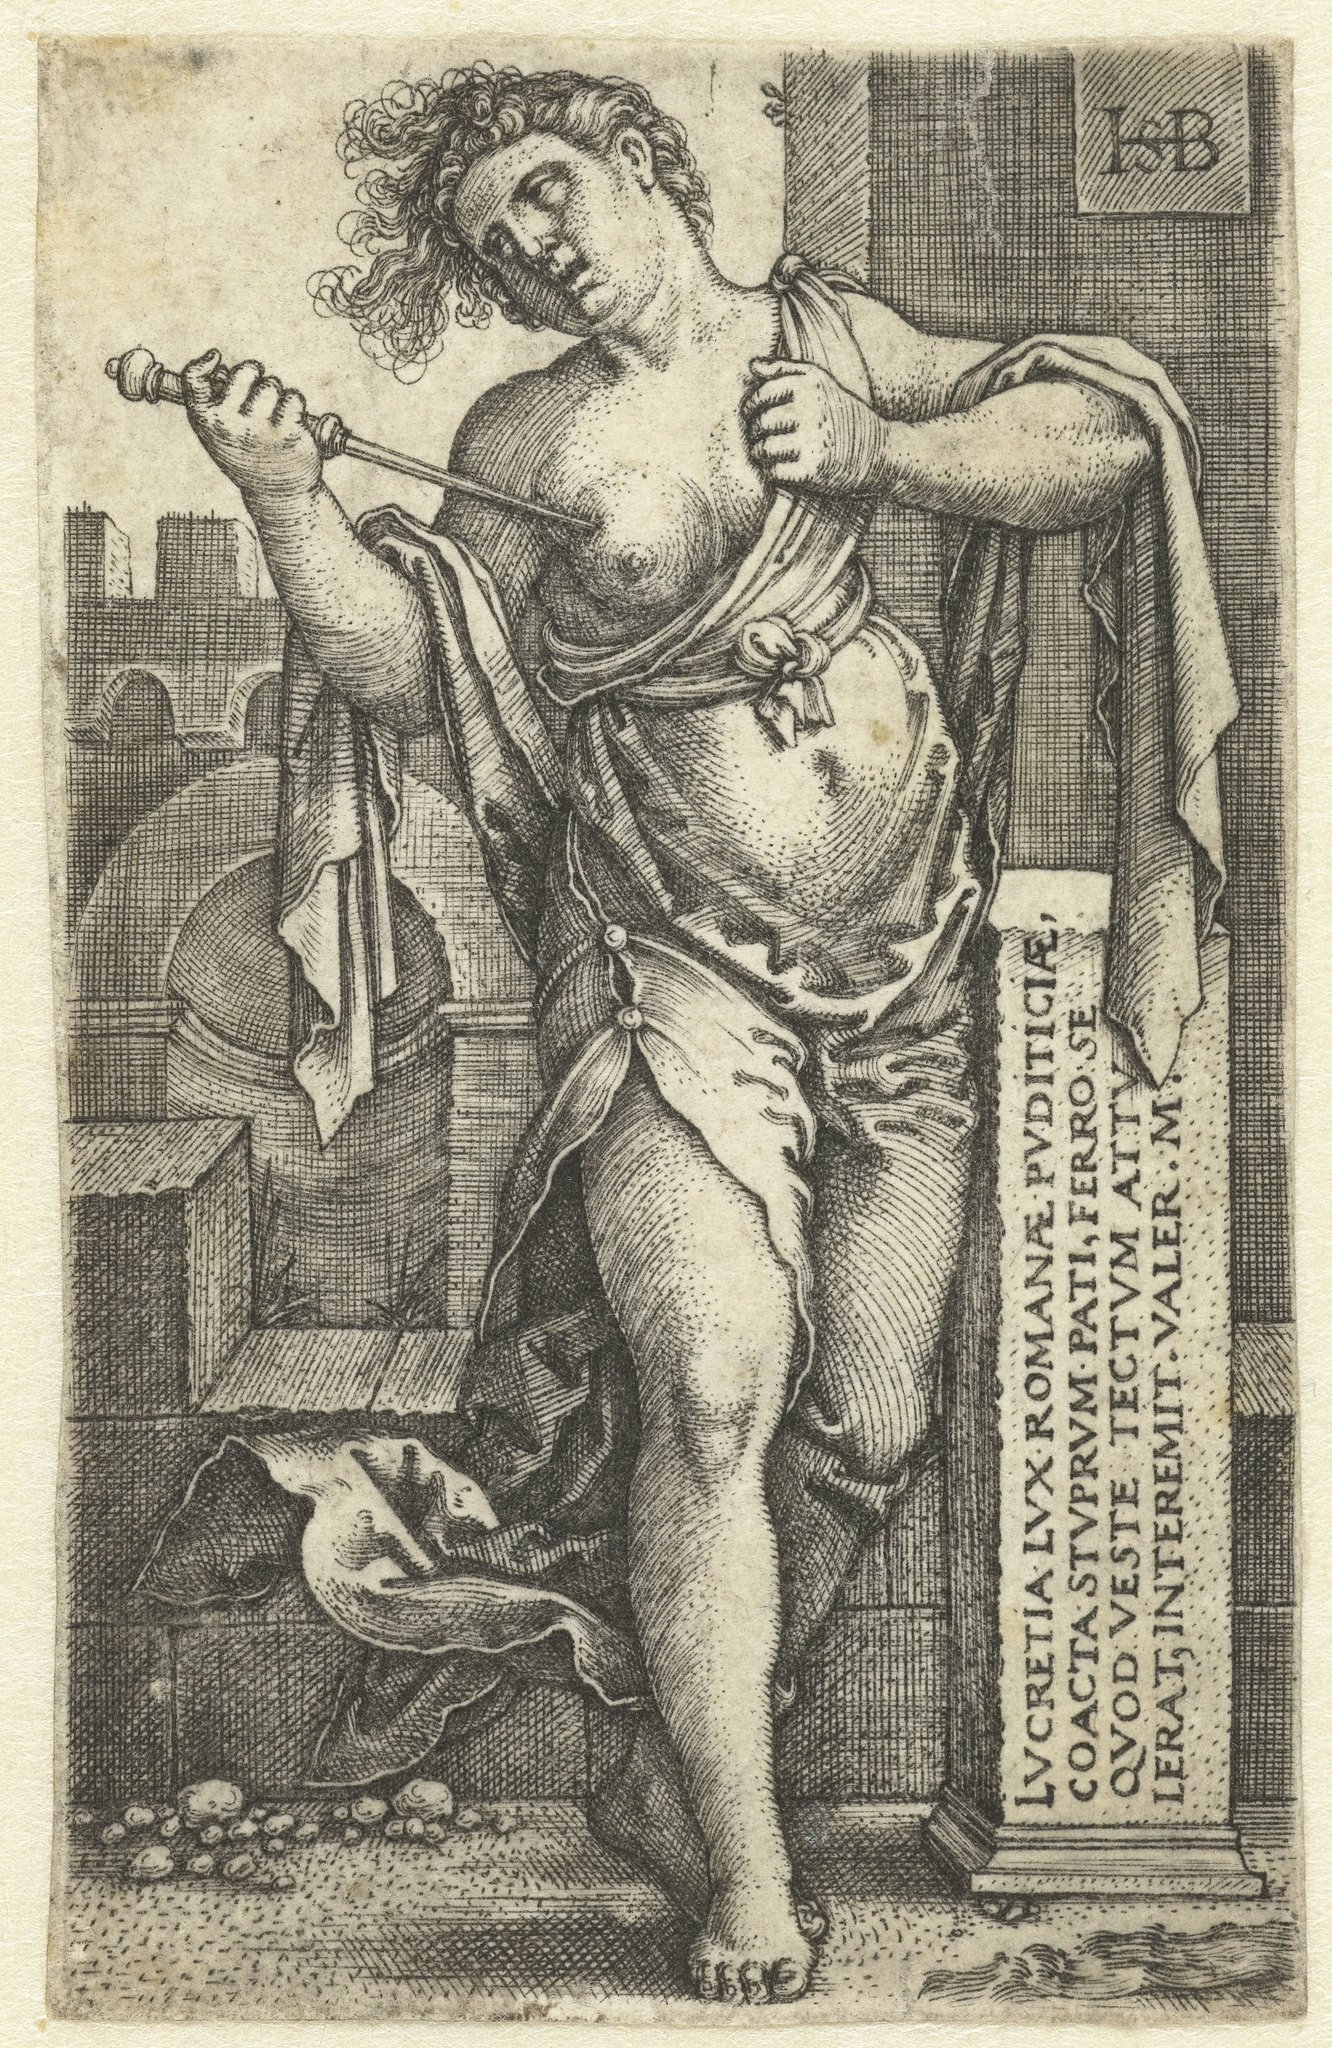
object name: print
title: Dood van Lucretia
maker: hans sebald beham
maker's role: designer, draughtsman, print maker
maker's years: 1500-1550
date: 1510-1550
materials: paper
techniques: engraving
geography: germany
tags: death of lucretia: she commits suicide by stabbing herself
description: Op een zuil staat het opschrift Lvcretia lvx romanae pvditiciae coacta stvprvm pati, ferro se qvod veste tectvm attvlerat, interemit valer M